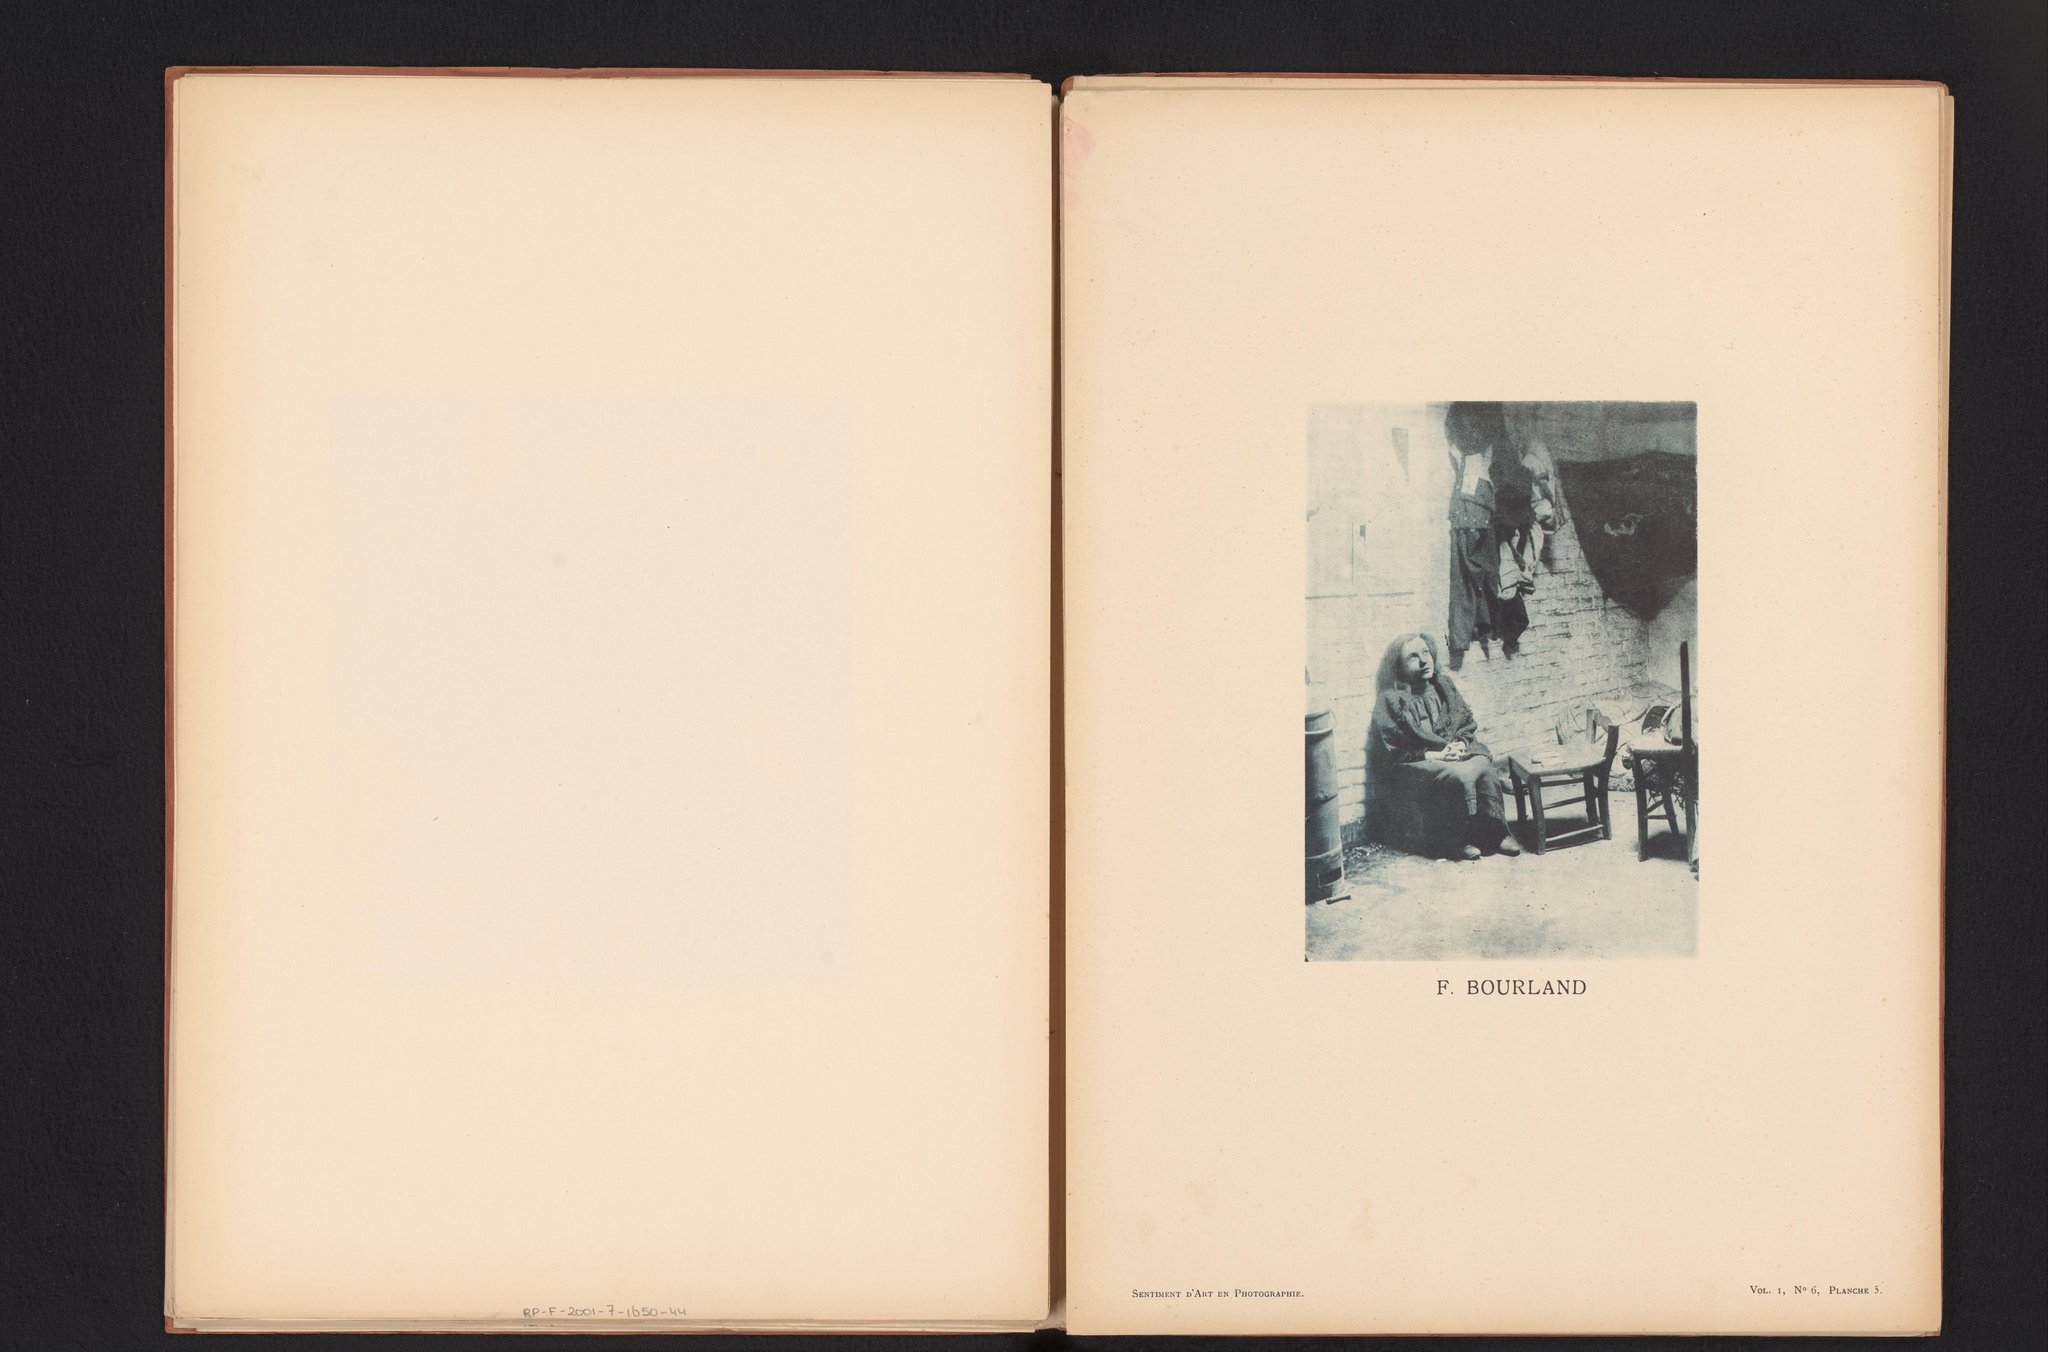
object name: photomechanical print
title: Kind op een kruk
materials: paper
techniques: photograph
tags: stool, child between toddler and youth (of undetermined sex)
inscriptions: number: ‘Vol. 1, No 6, Planche 5.’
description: Deze prent maakt deel uit van 8 omslagen met 22 tekstbladen en 89 prenten op losse bladen in en tussen de omslagen.